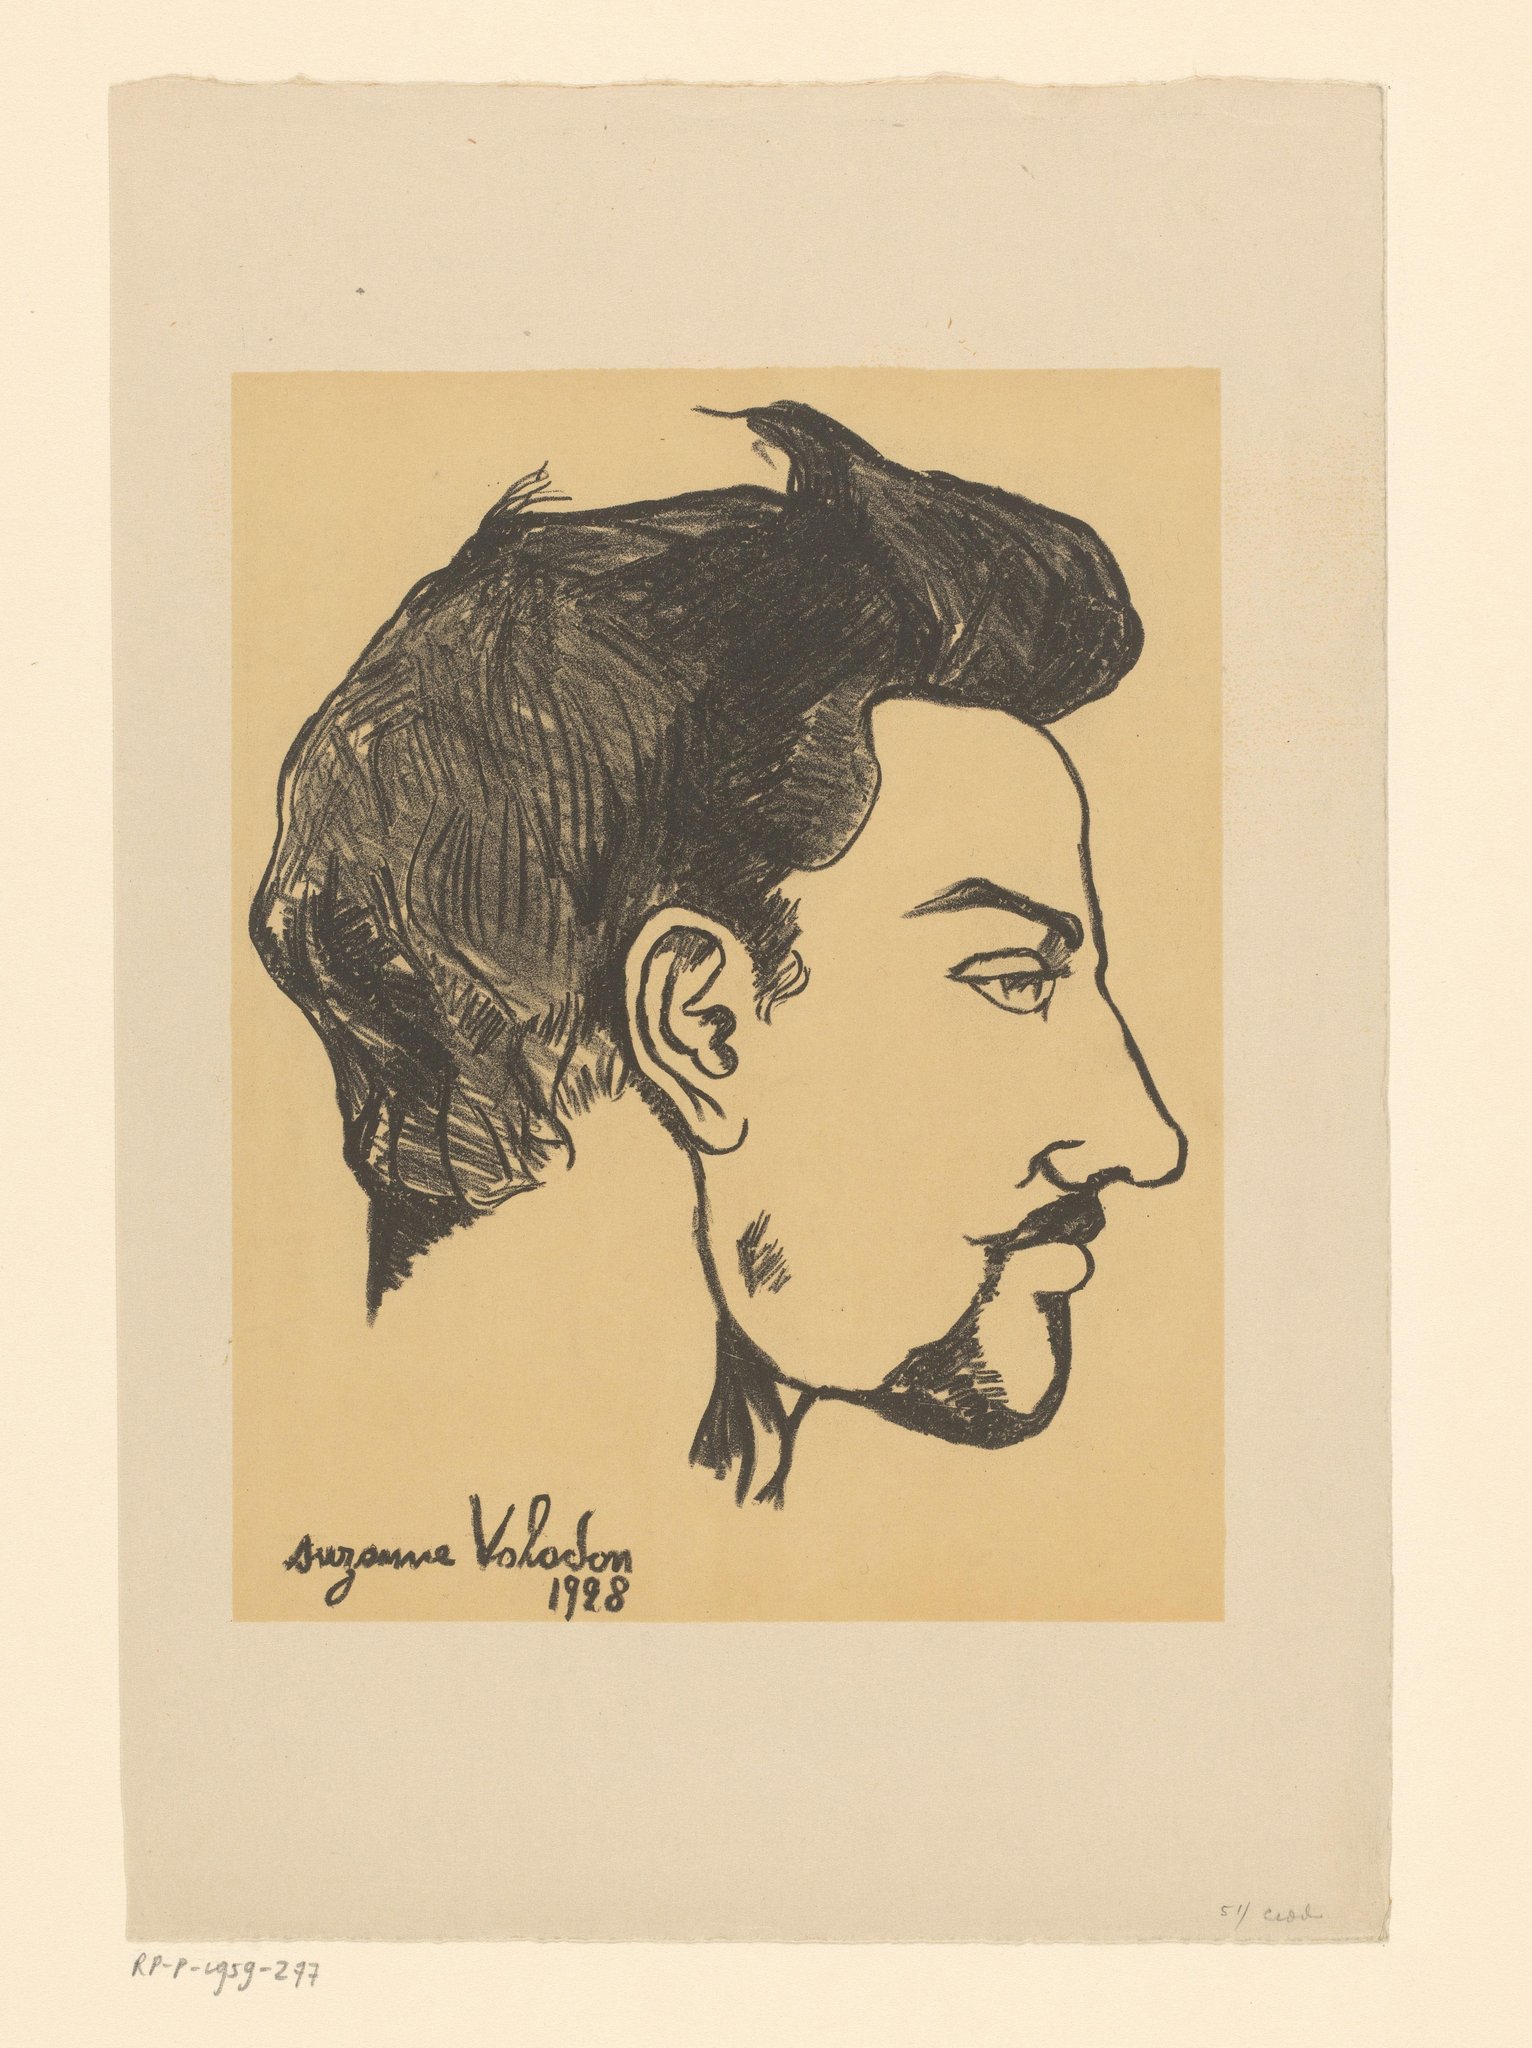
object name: print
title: Portret van Maurice Utrillo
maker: suzanne valadon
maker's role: print maker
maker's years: 1865-1938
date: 1928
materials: paper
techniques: tone lithography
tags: paris, print maker, maurice utrillo, historical persons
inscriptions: collector's mark: Lugt 2760, collector's mark: Lugt 2228, inscription: ‘51/ [...]’